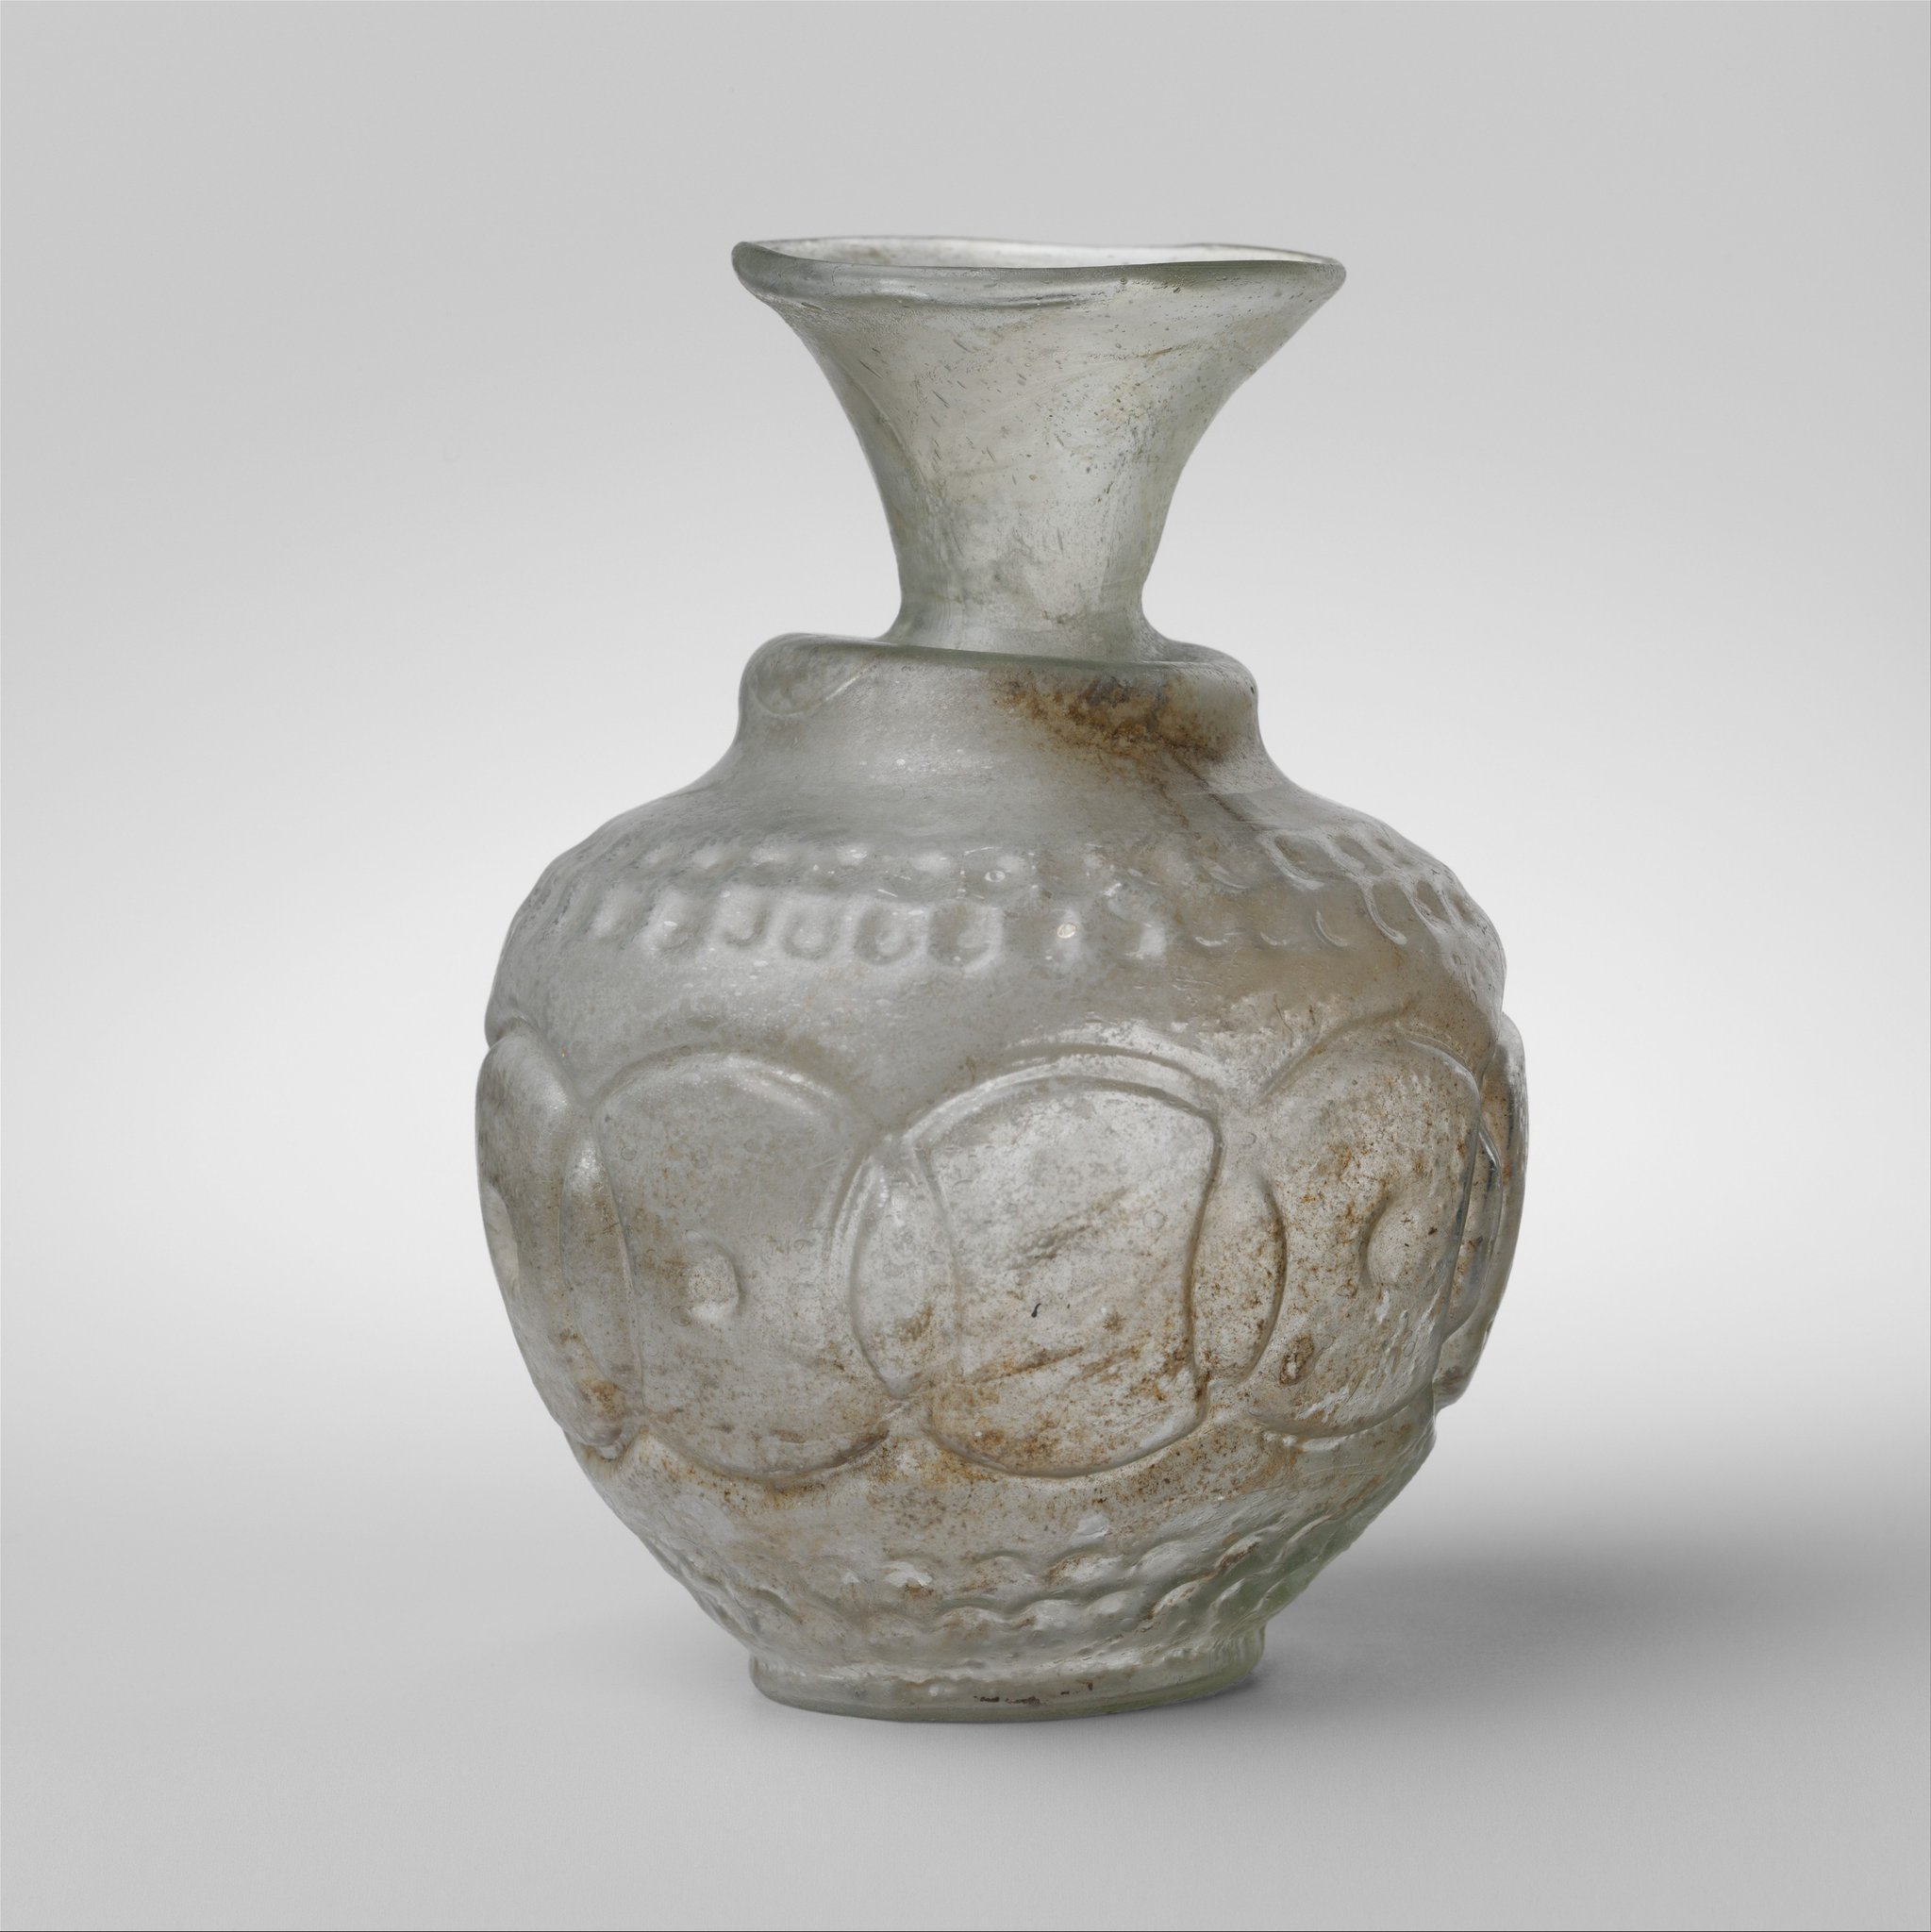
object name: flask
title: Glass flask decorated with intersecting circles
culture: roman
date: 101-300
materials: glass